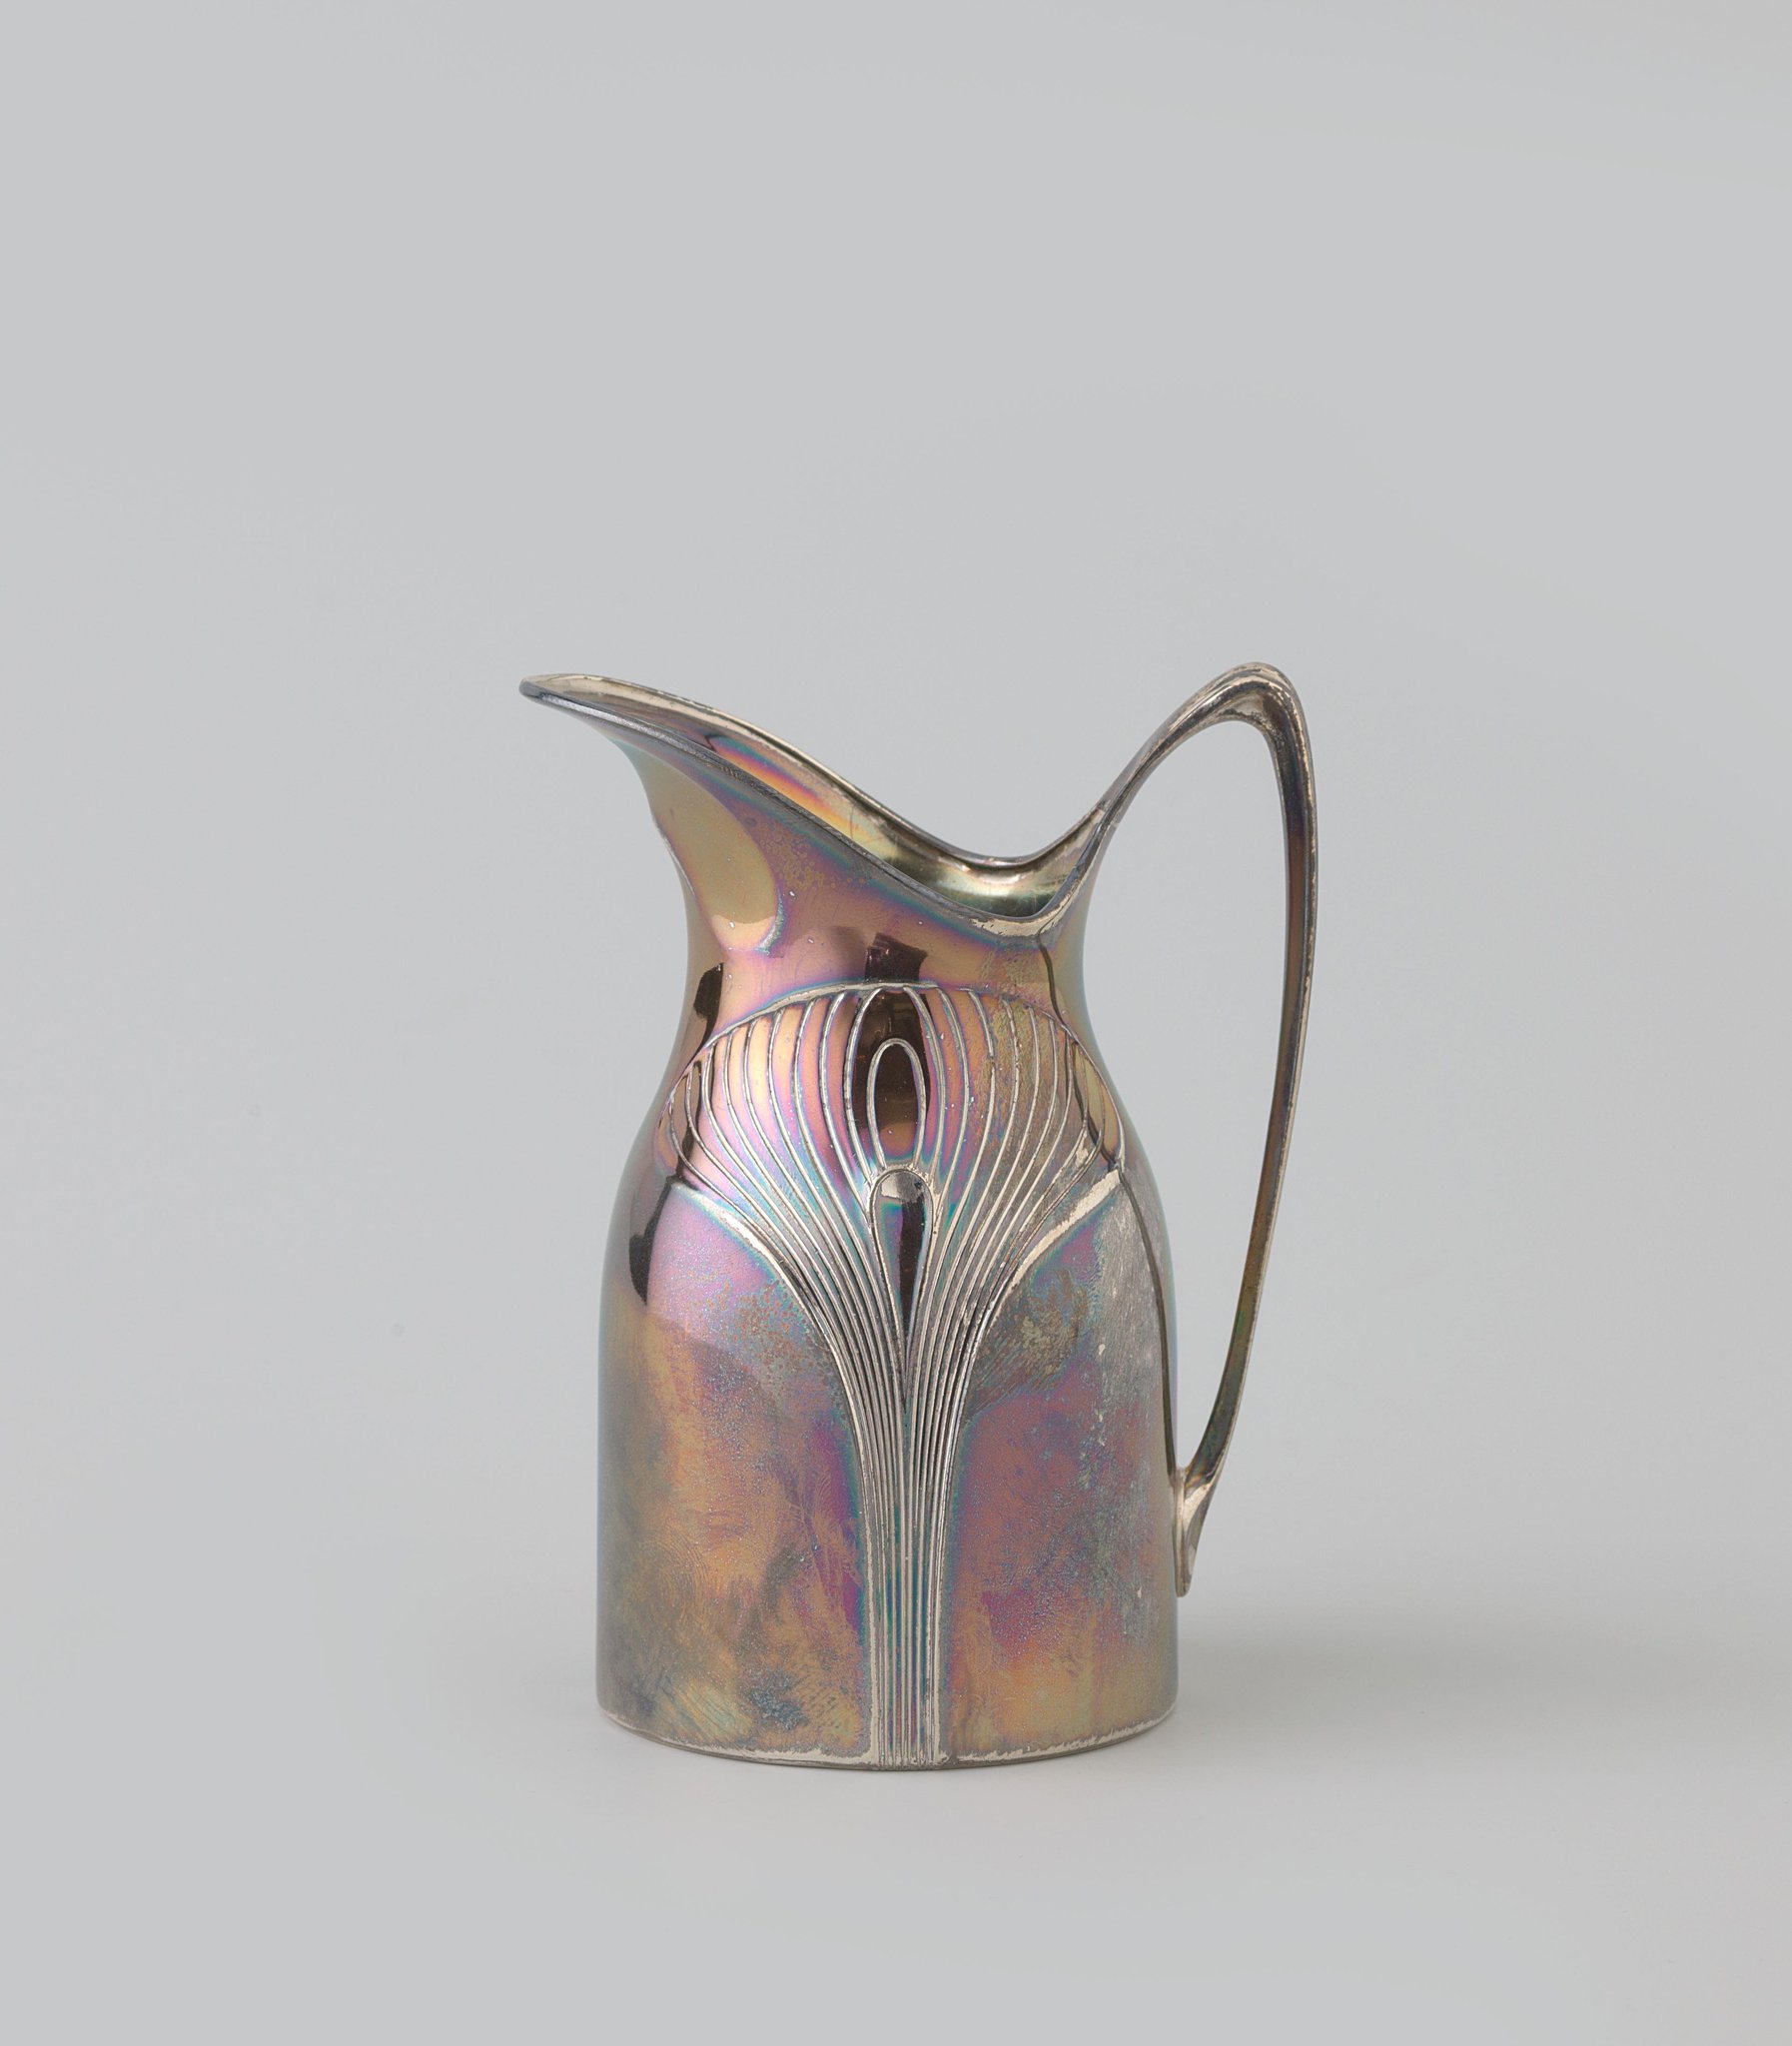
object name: milk jug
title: Melkkan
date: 1905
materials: silver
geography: germany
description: Melkkan van zilver, met gladde, wijde, hoogoplopende tuit en versierd met twee palmetten.